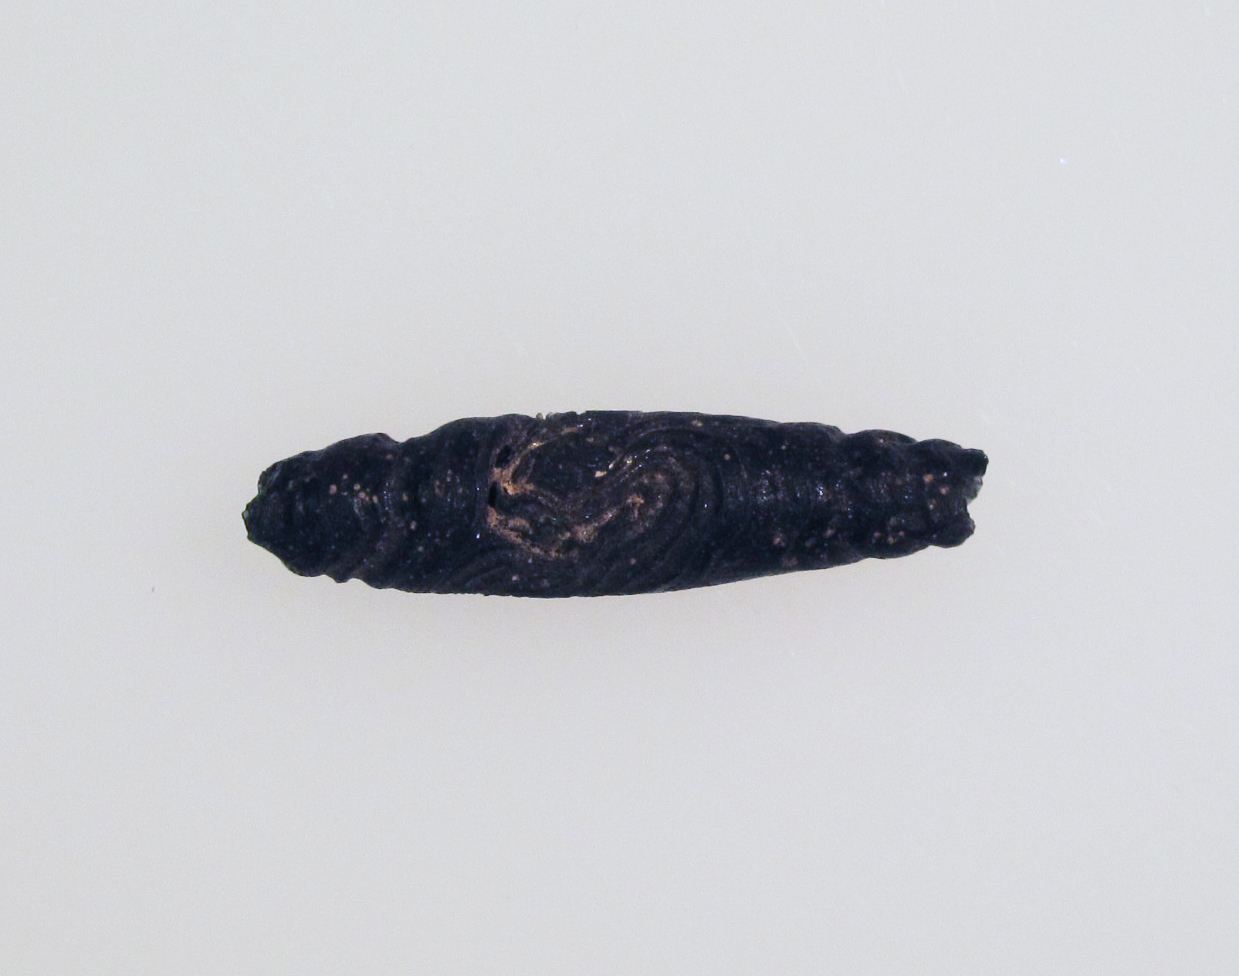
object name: bead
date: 7000 BCE-330 CE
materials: glass